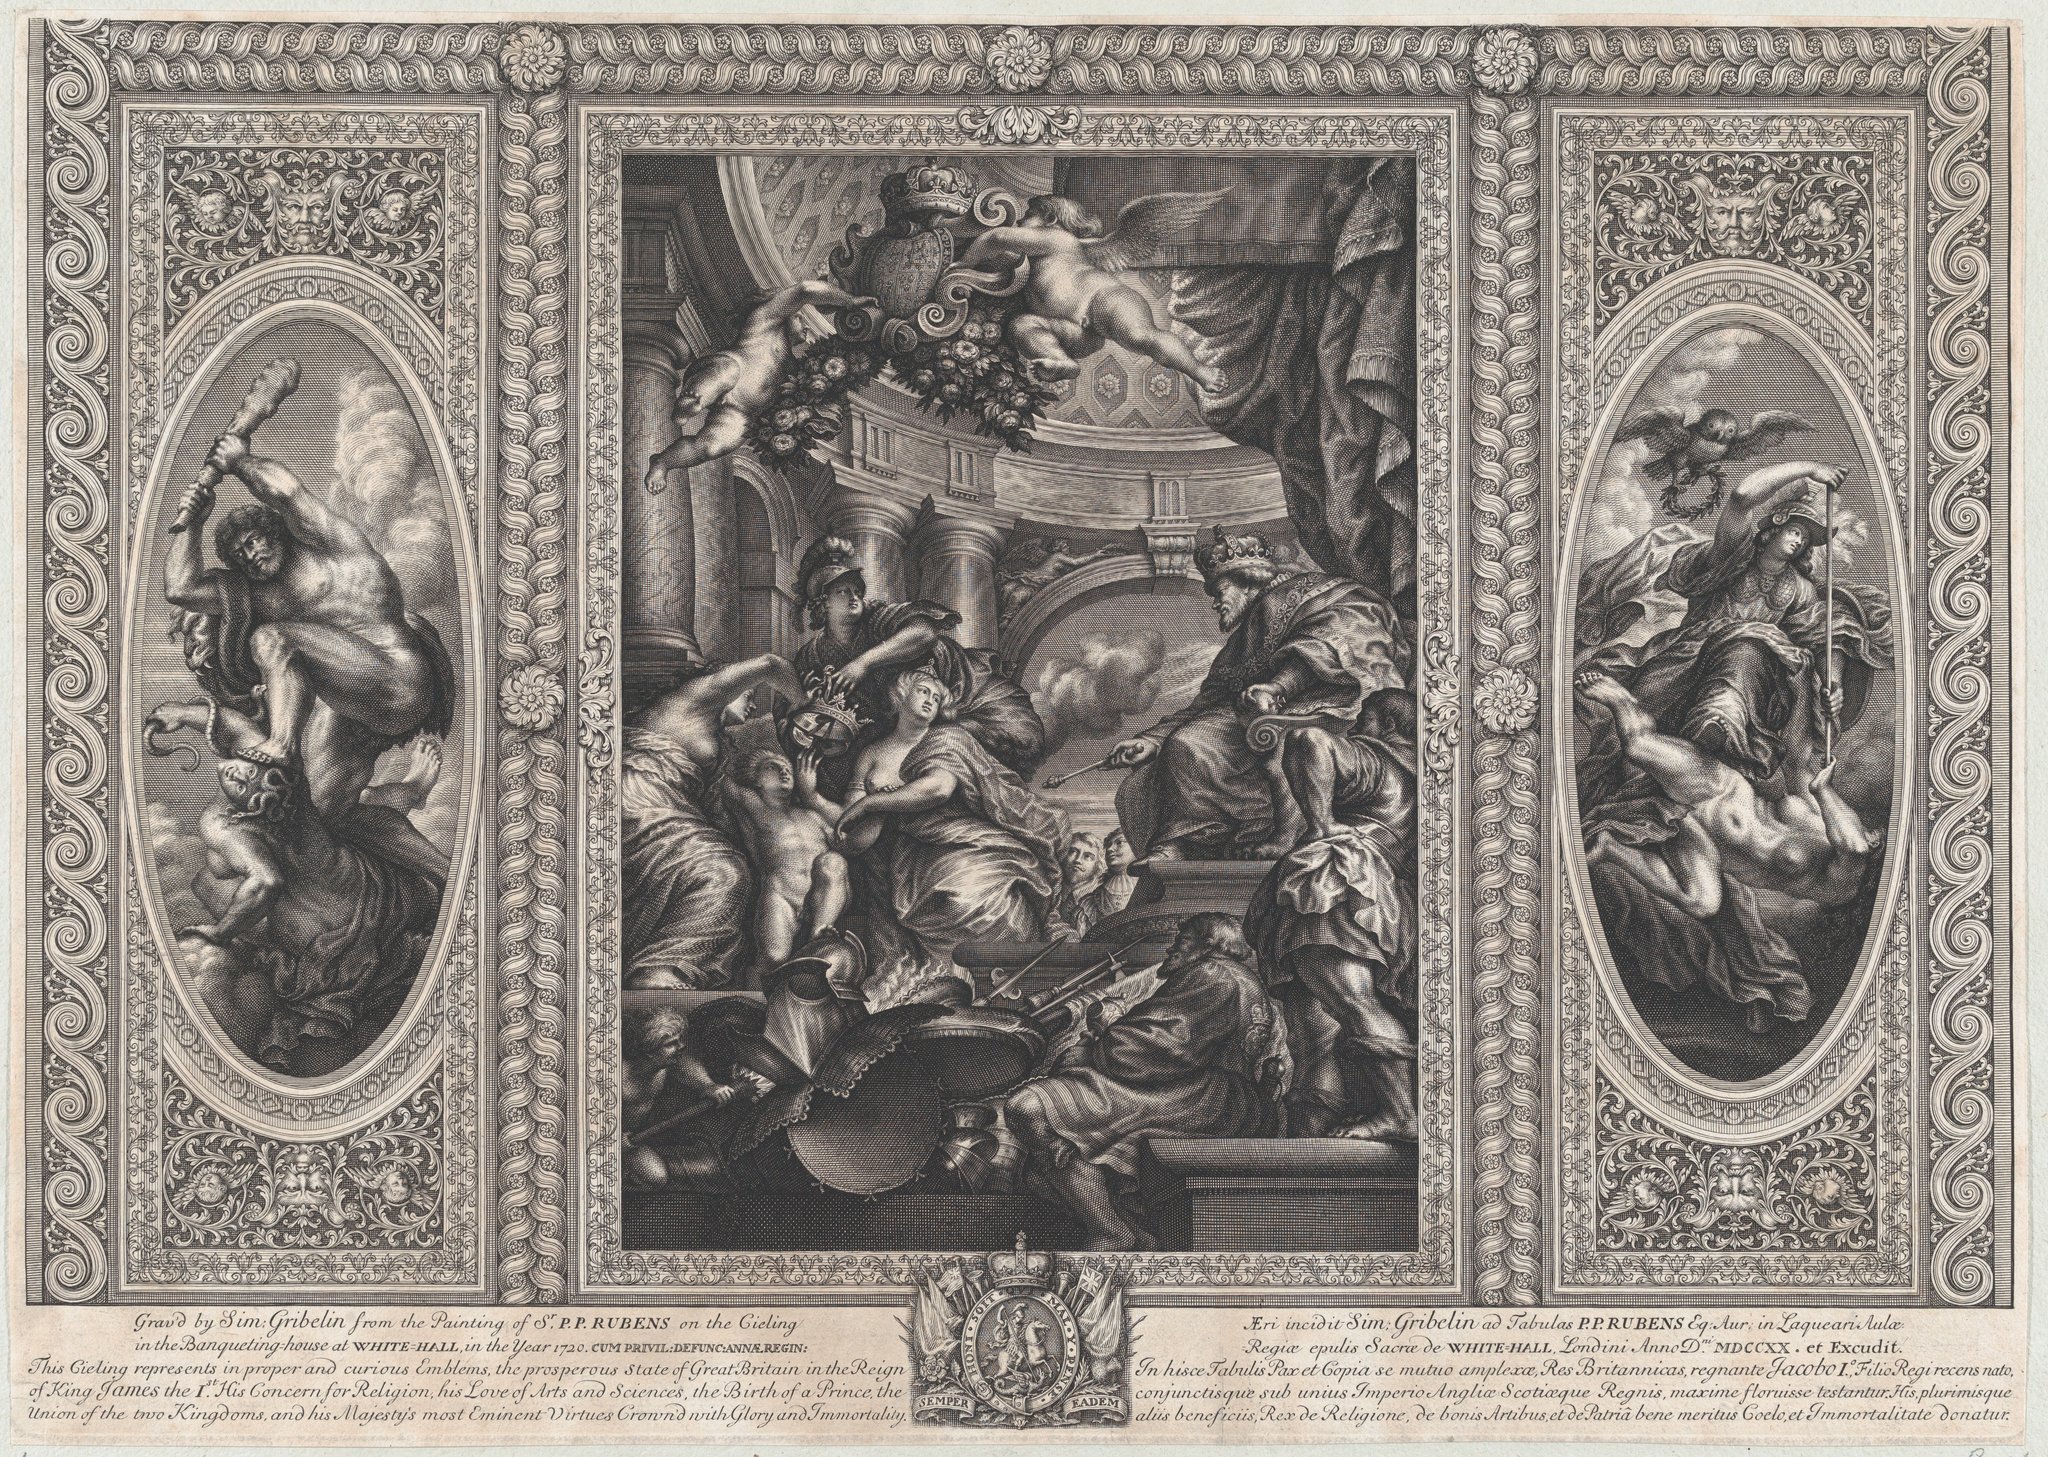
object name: print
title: An allegorical scene showing the benefits of James' reign at center, Wise Government trampling Rebellion at right, and Liberty trampling Avarice at left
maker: simon gribelin ii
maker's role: artist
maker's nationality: french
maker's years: 1661-1733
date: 1720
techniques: engraving